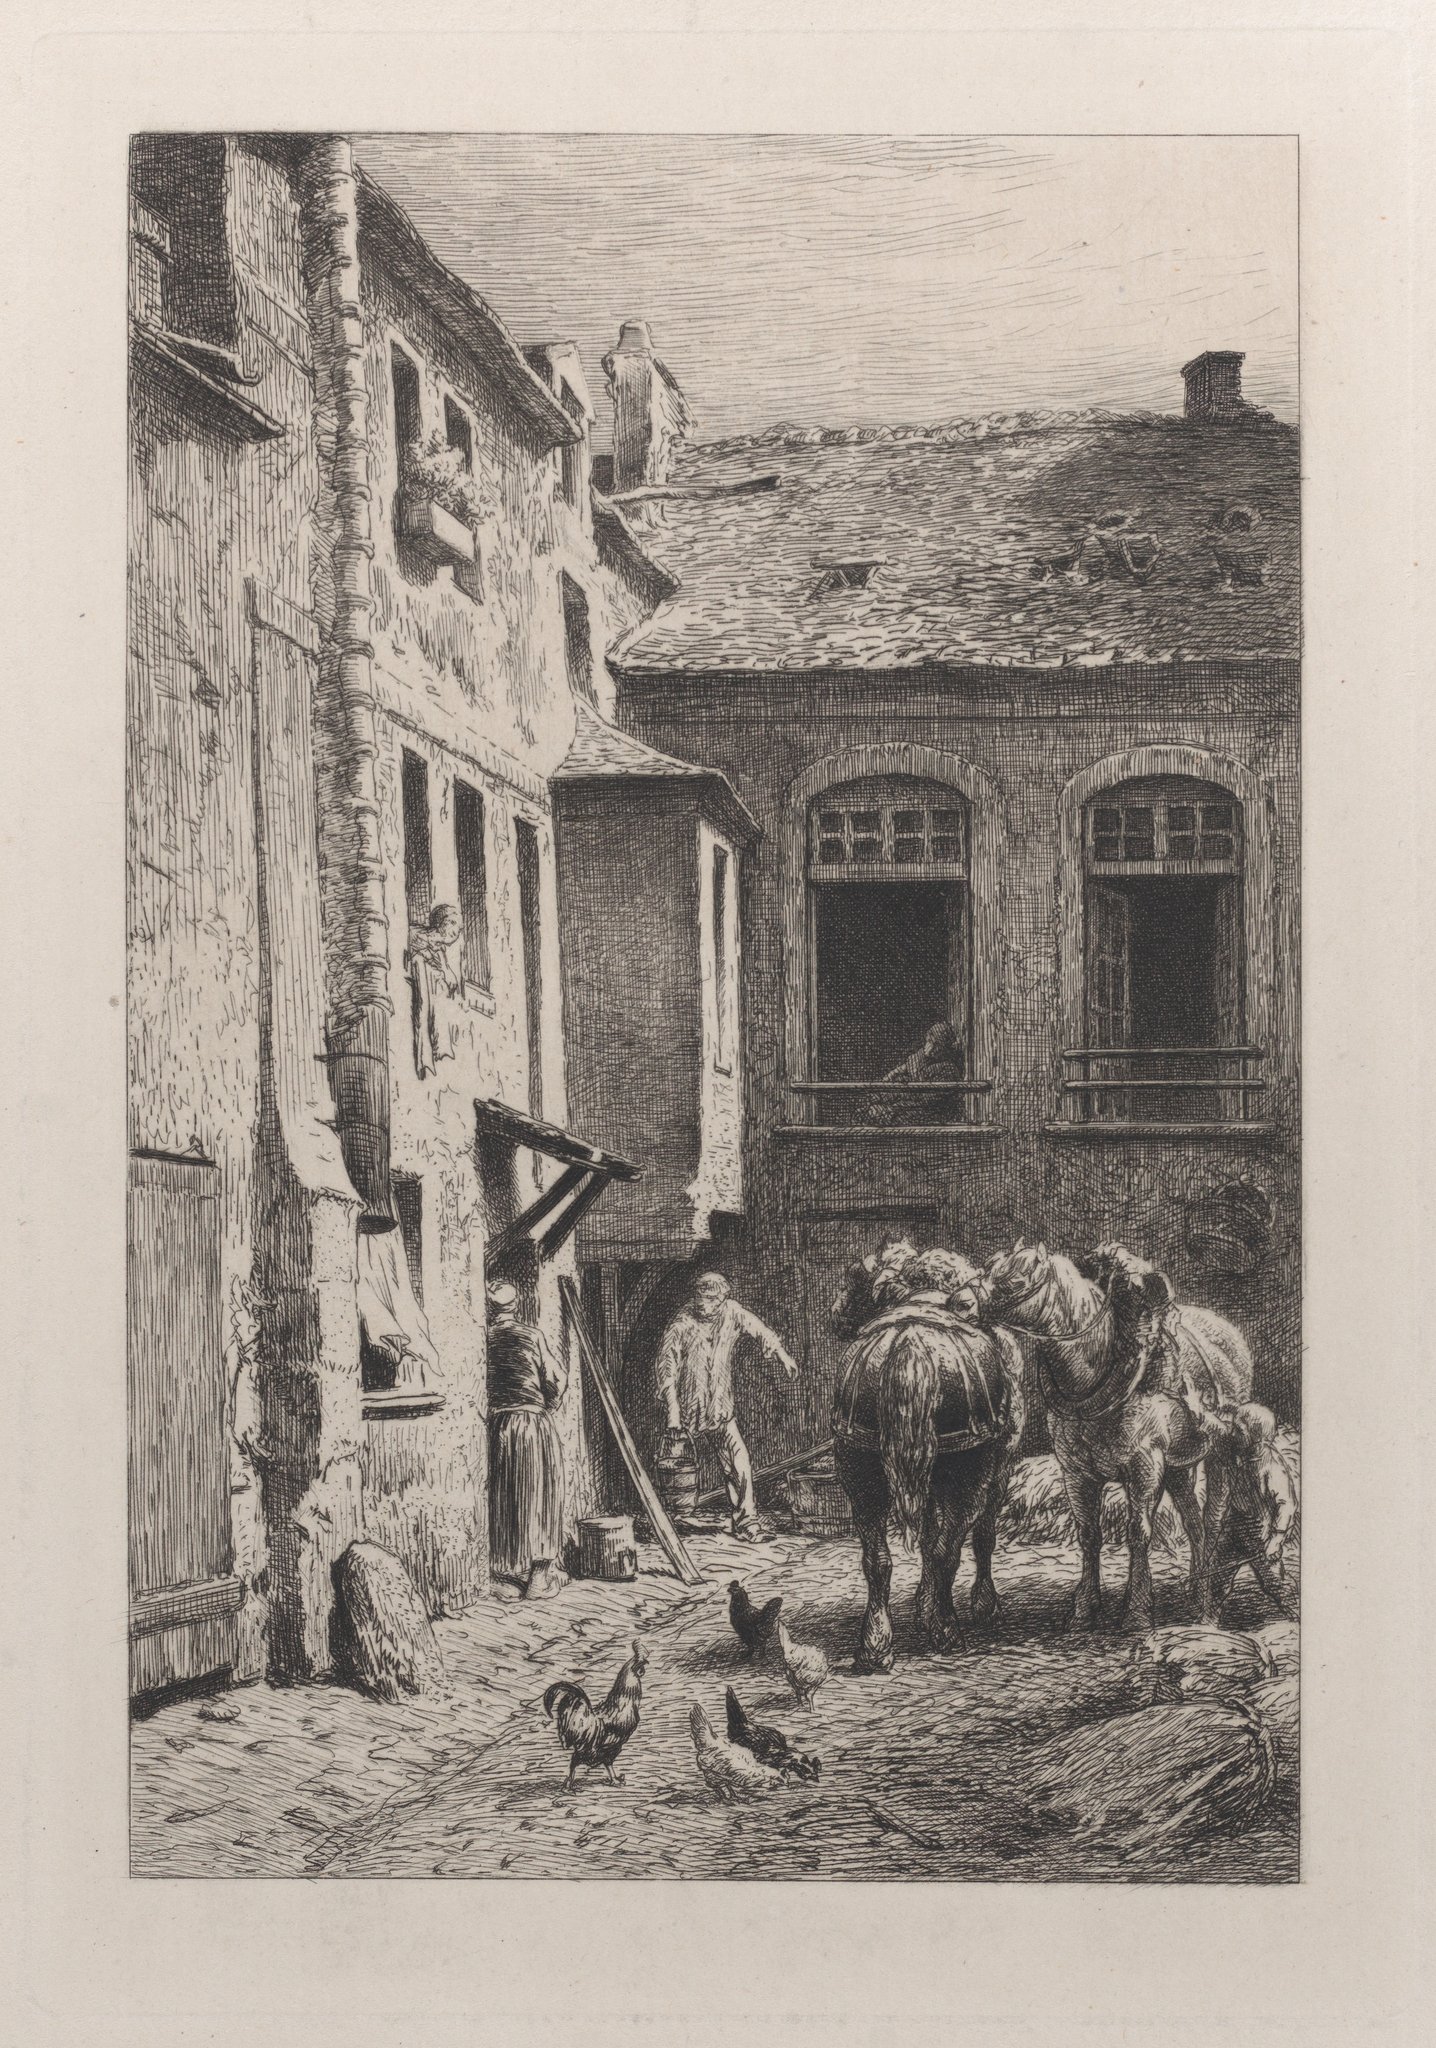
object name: print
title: A Paris Courtyard in 1865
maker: charles émile jacque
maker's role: artist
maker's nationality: french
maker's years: 1813-1894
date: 1865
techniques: etching